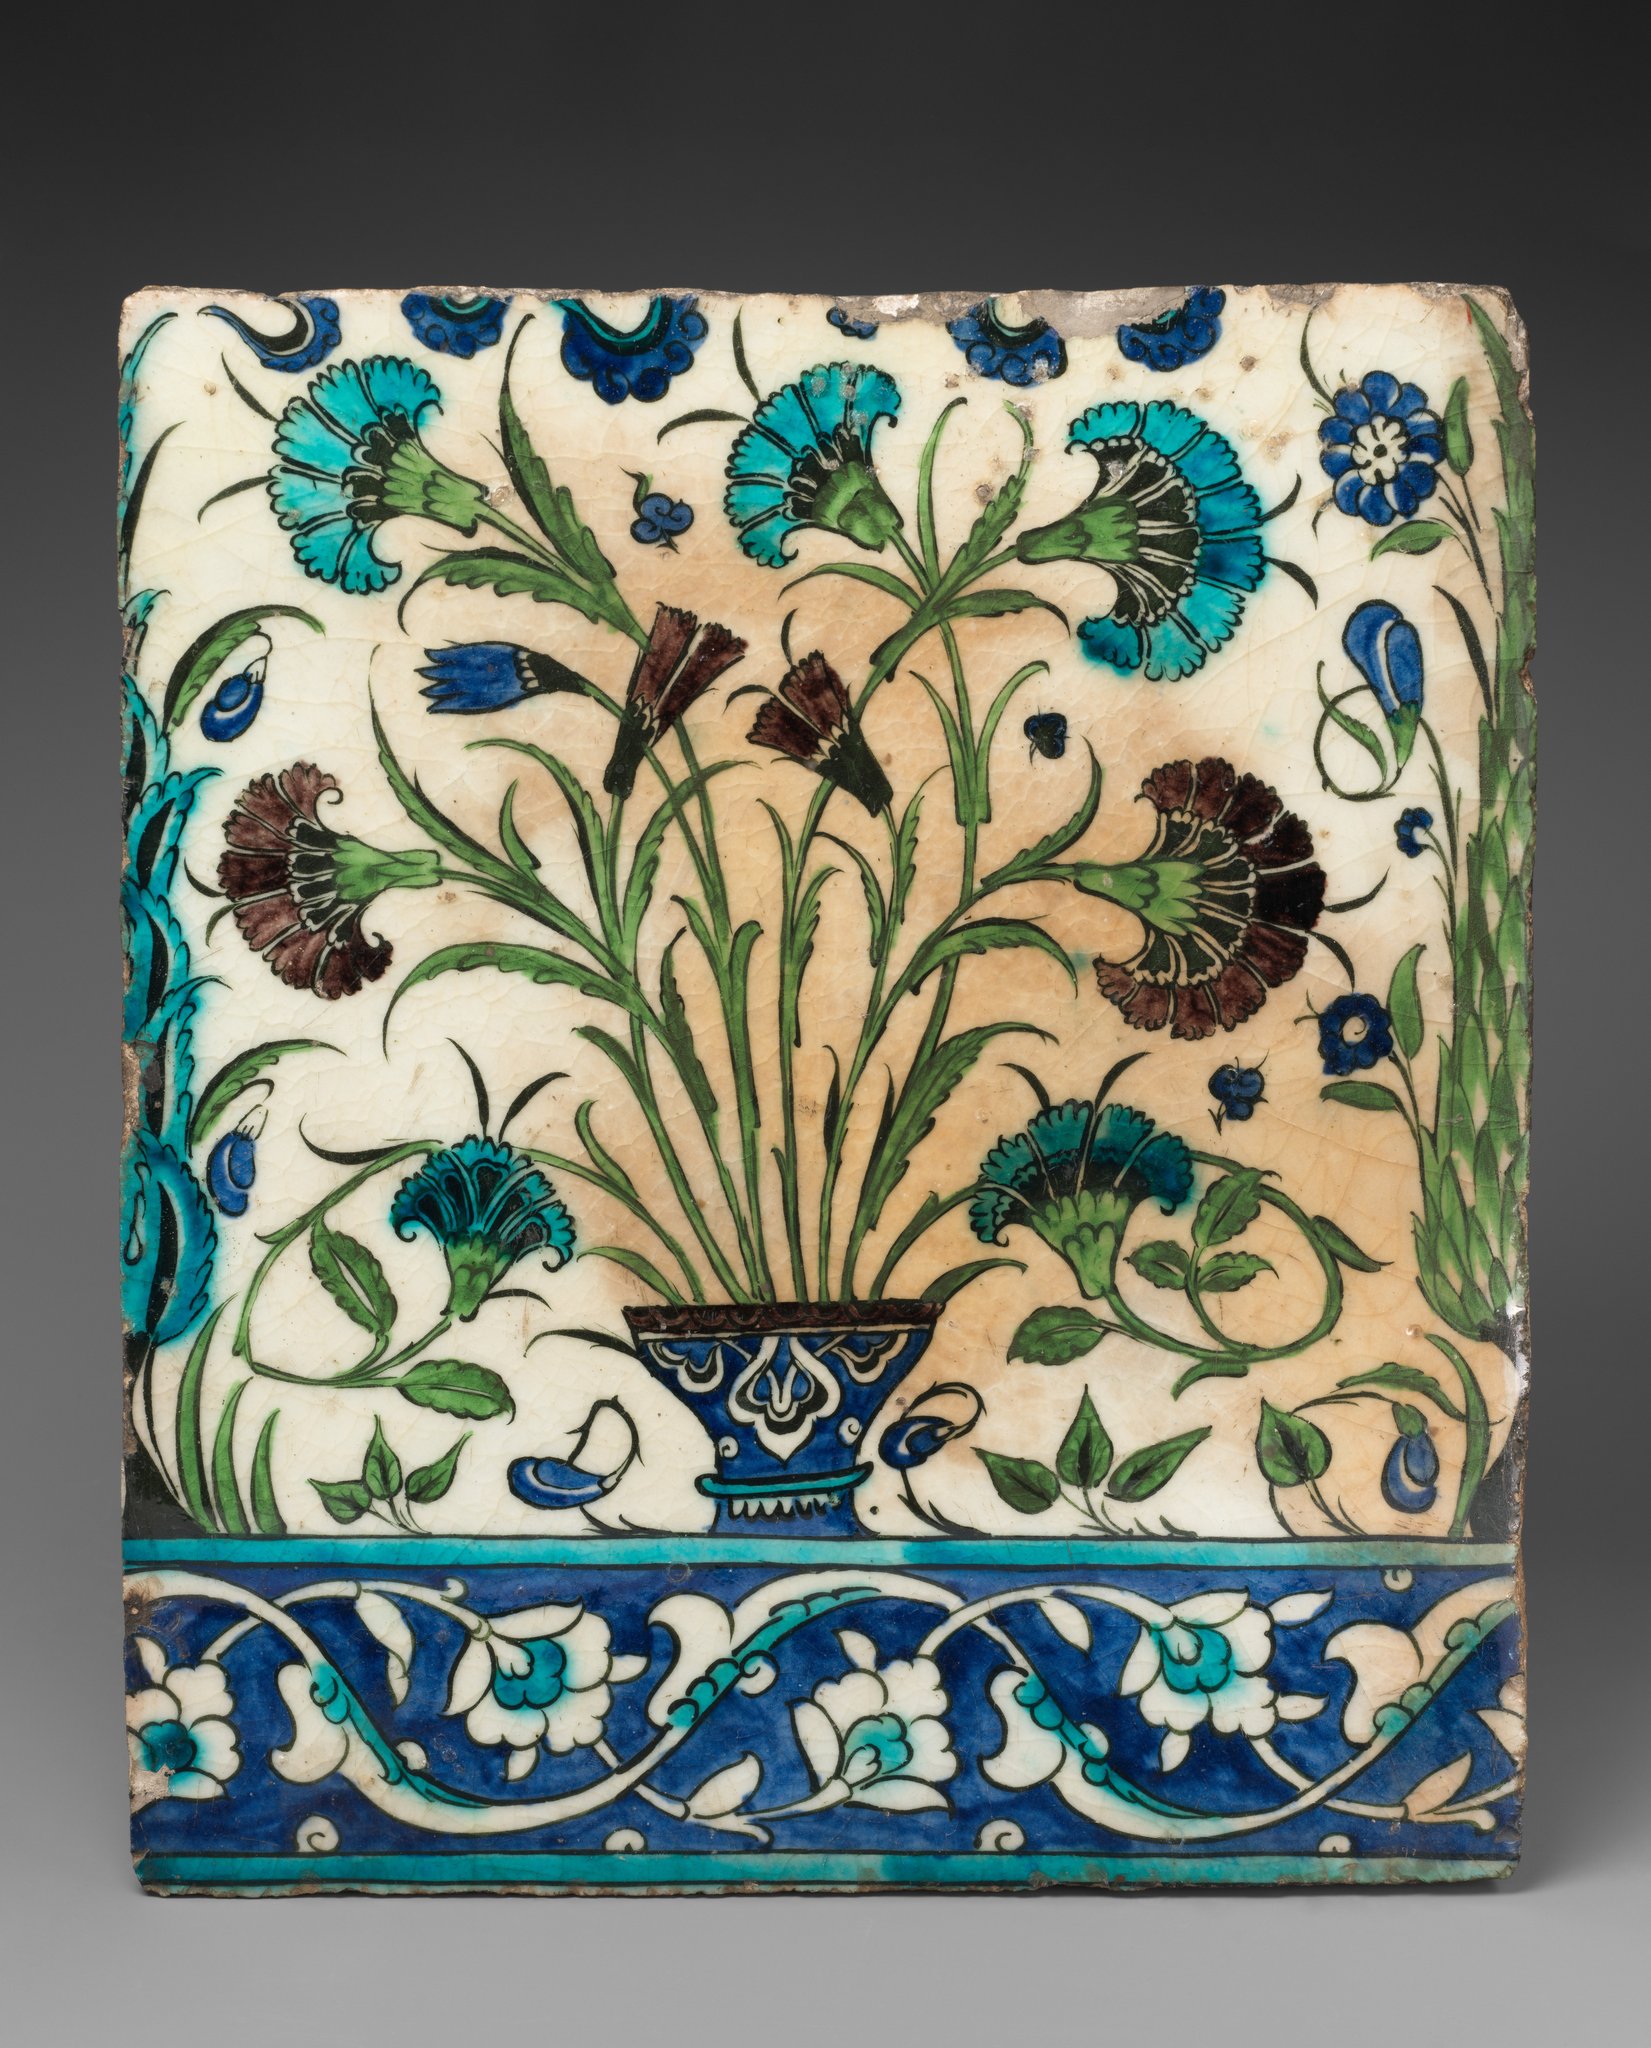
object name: tile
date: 1567-1600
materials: stonepaste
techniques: glazing, painting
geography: syria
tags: flowers